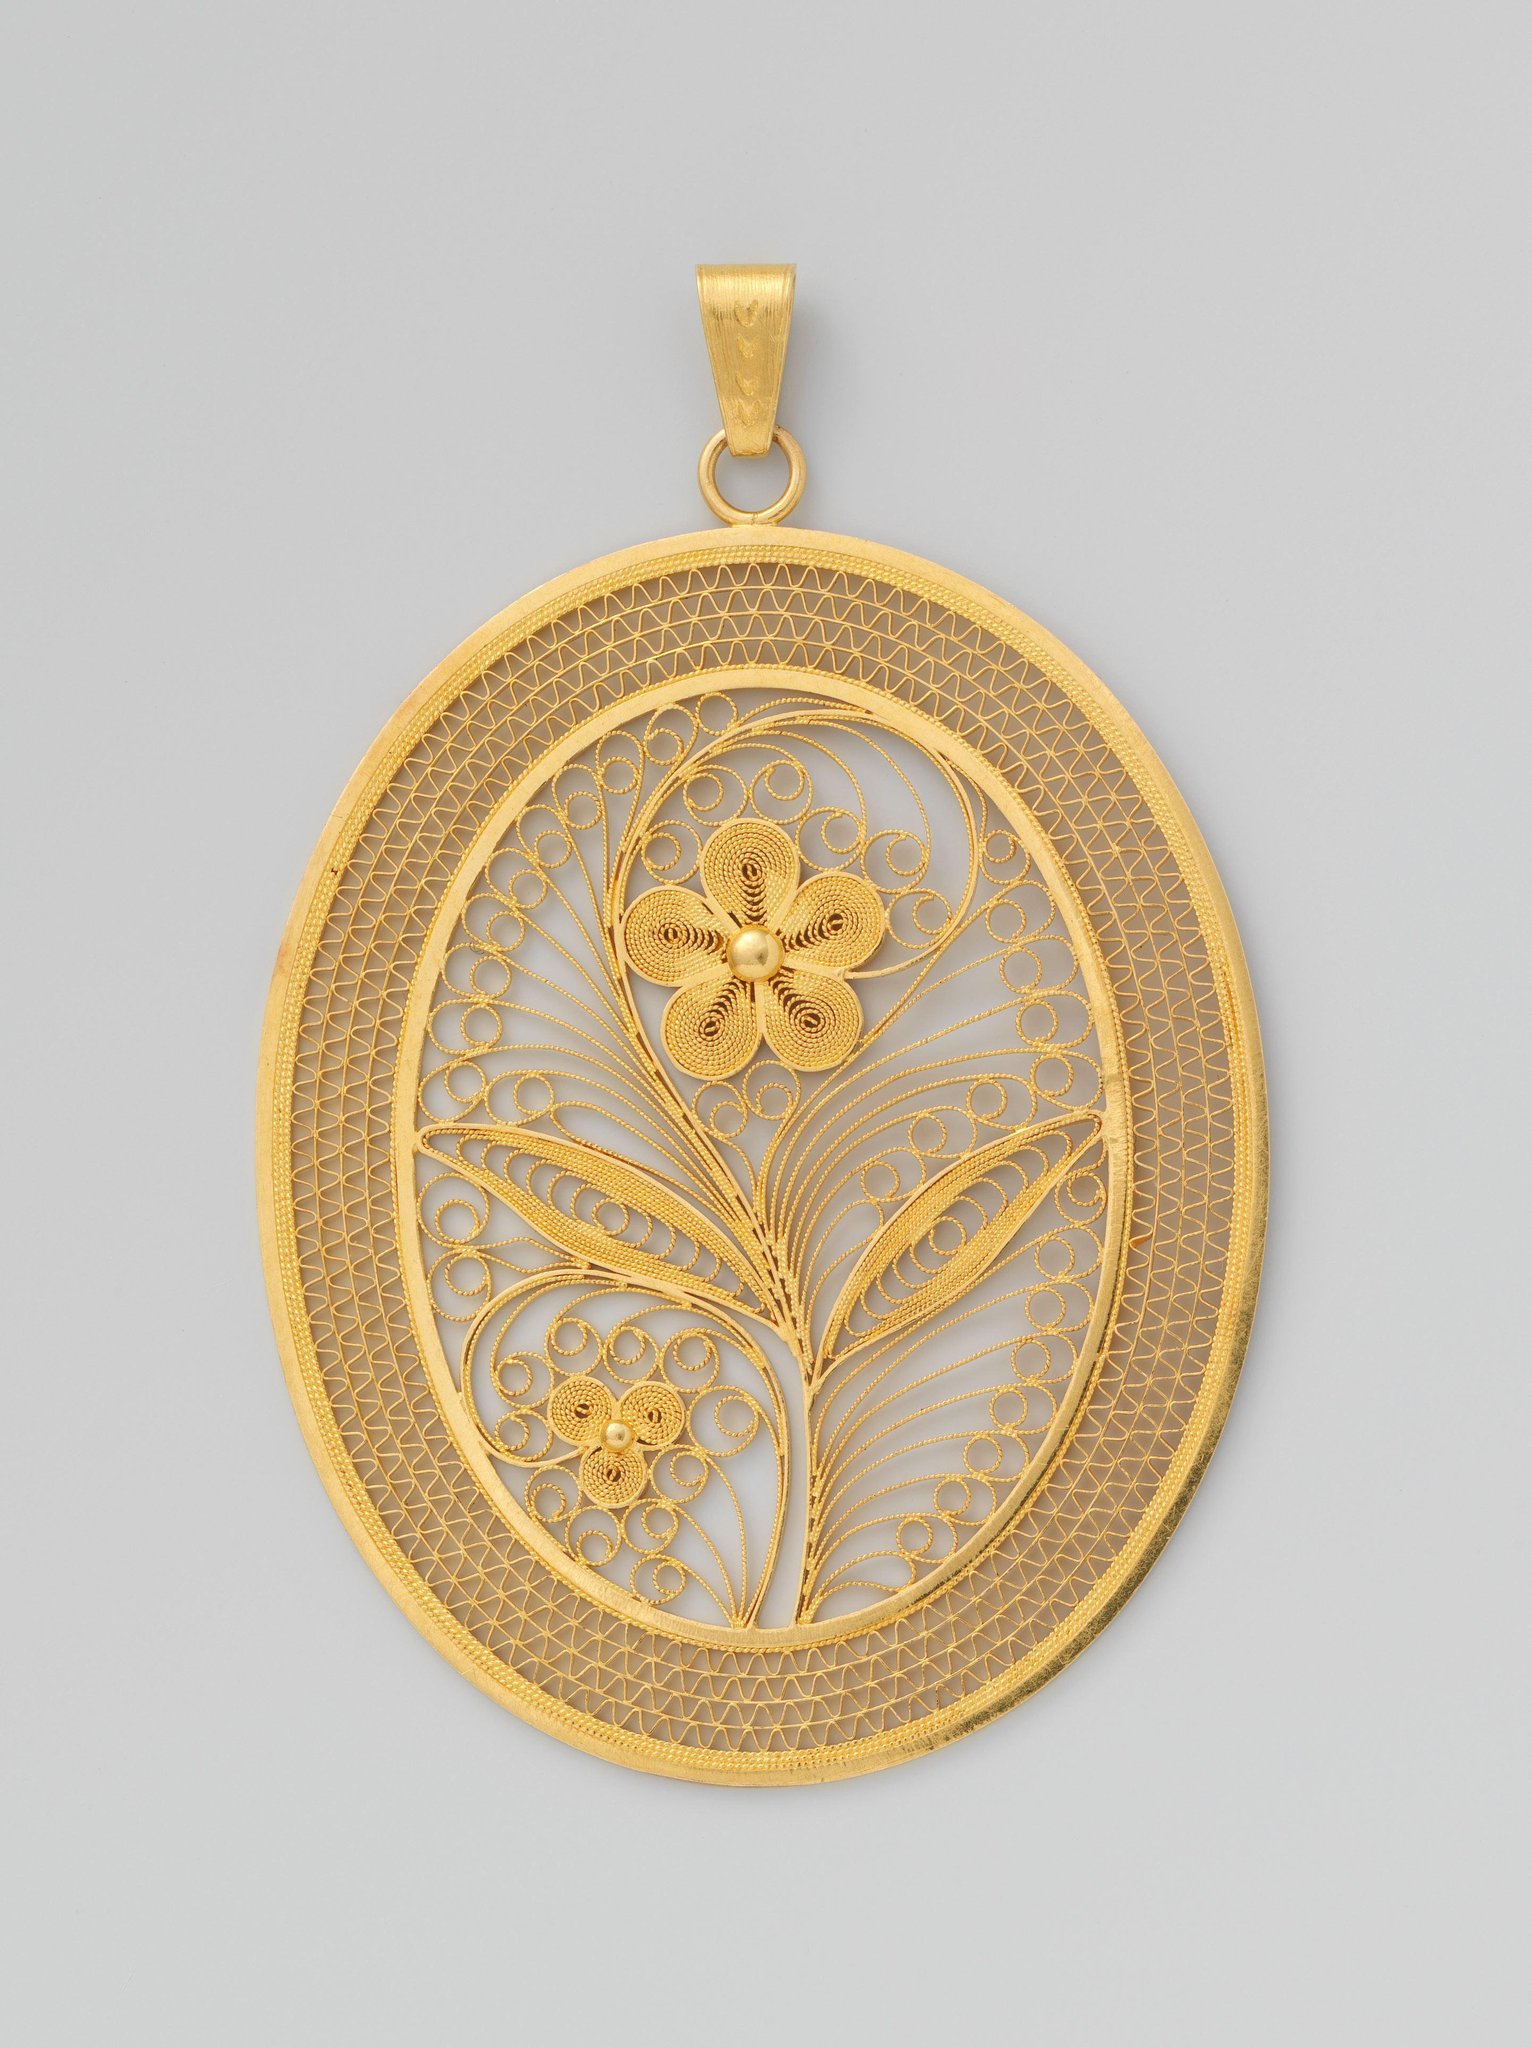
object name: pendant jewelry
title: Hanger met viooltje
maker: Anonymous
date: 1930-1940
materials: gold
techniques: filigree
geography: dutch east indies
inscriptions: maker's mark: ‘JM’, alloy mark: ‘833’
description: Ovale hanger van goudfiligrein met viooltje voorzien van een plaatoog.